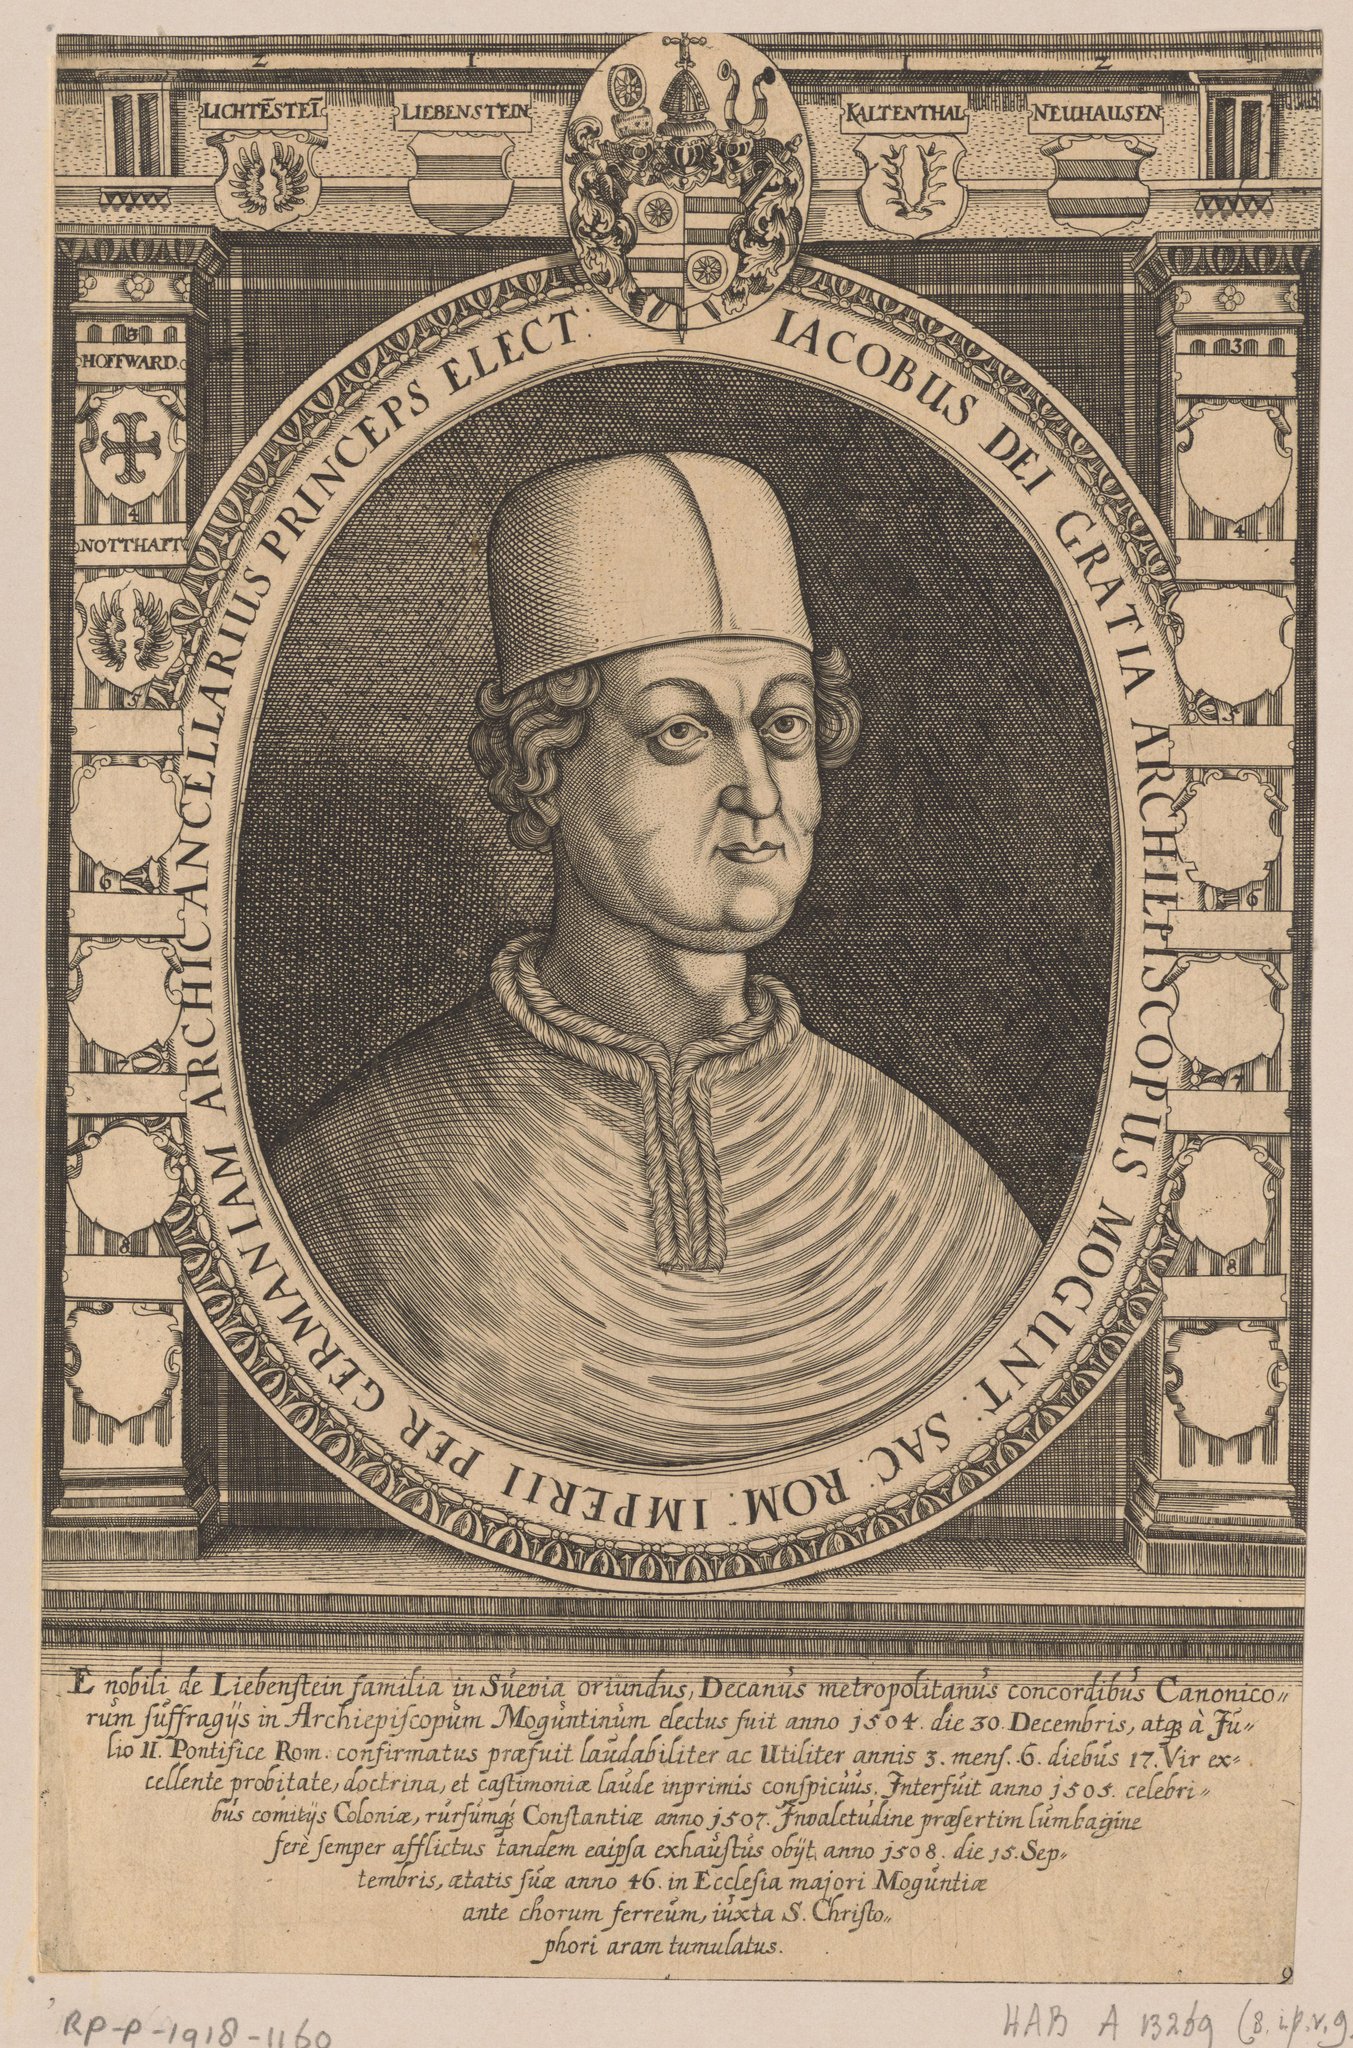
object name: print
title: Portret van Jakob von Liebenstein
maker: sebastian furck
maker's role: print maker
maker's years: 1600-1655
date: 1610-1655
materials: paper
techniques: engraving, etching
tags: archbishop, bishop, etc. (roman catholic), column, pillar ~ architecture, ornament ~ medallion, historical persons, armorial bearing, heraldry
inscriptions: collector's mark: Lugt 2233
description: Rechtsonder genummerd: 9. Met aan weerszijden van het portret in medaillon, en boven het portret, deels oningevulde familiewapens. Onder het portret tekst in het Latijn.